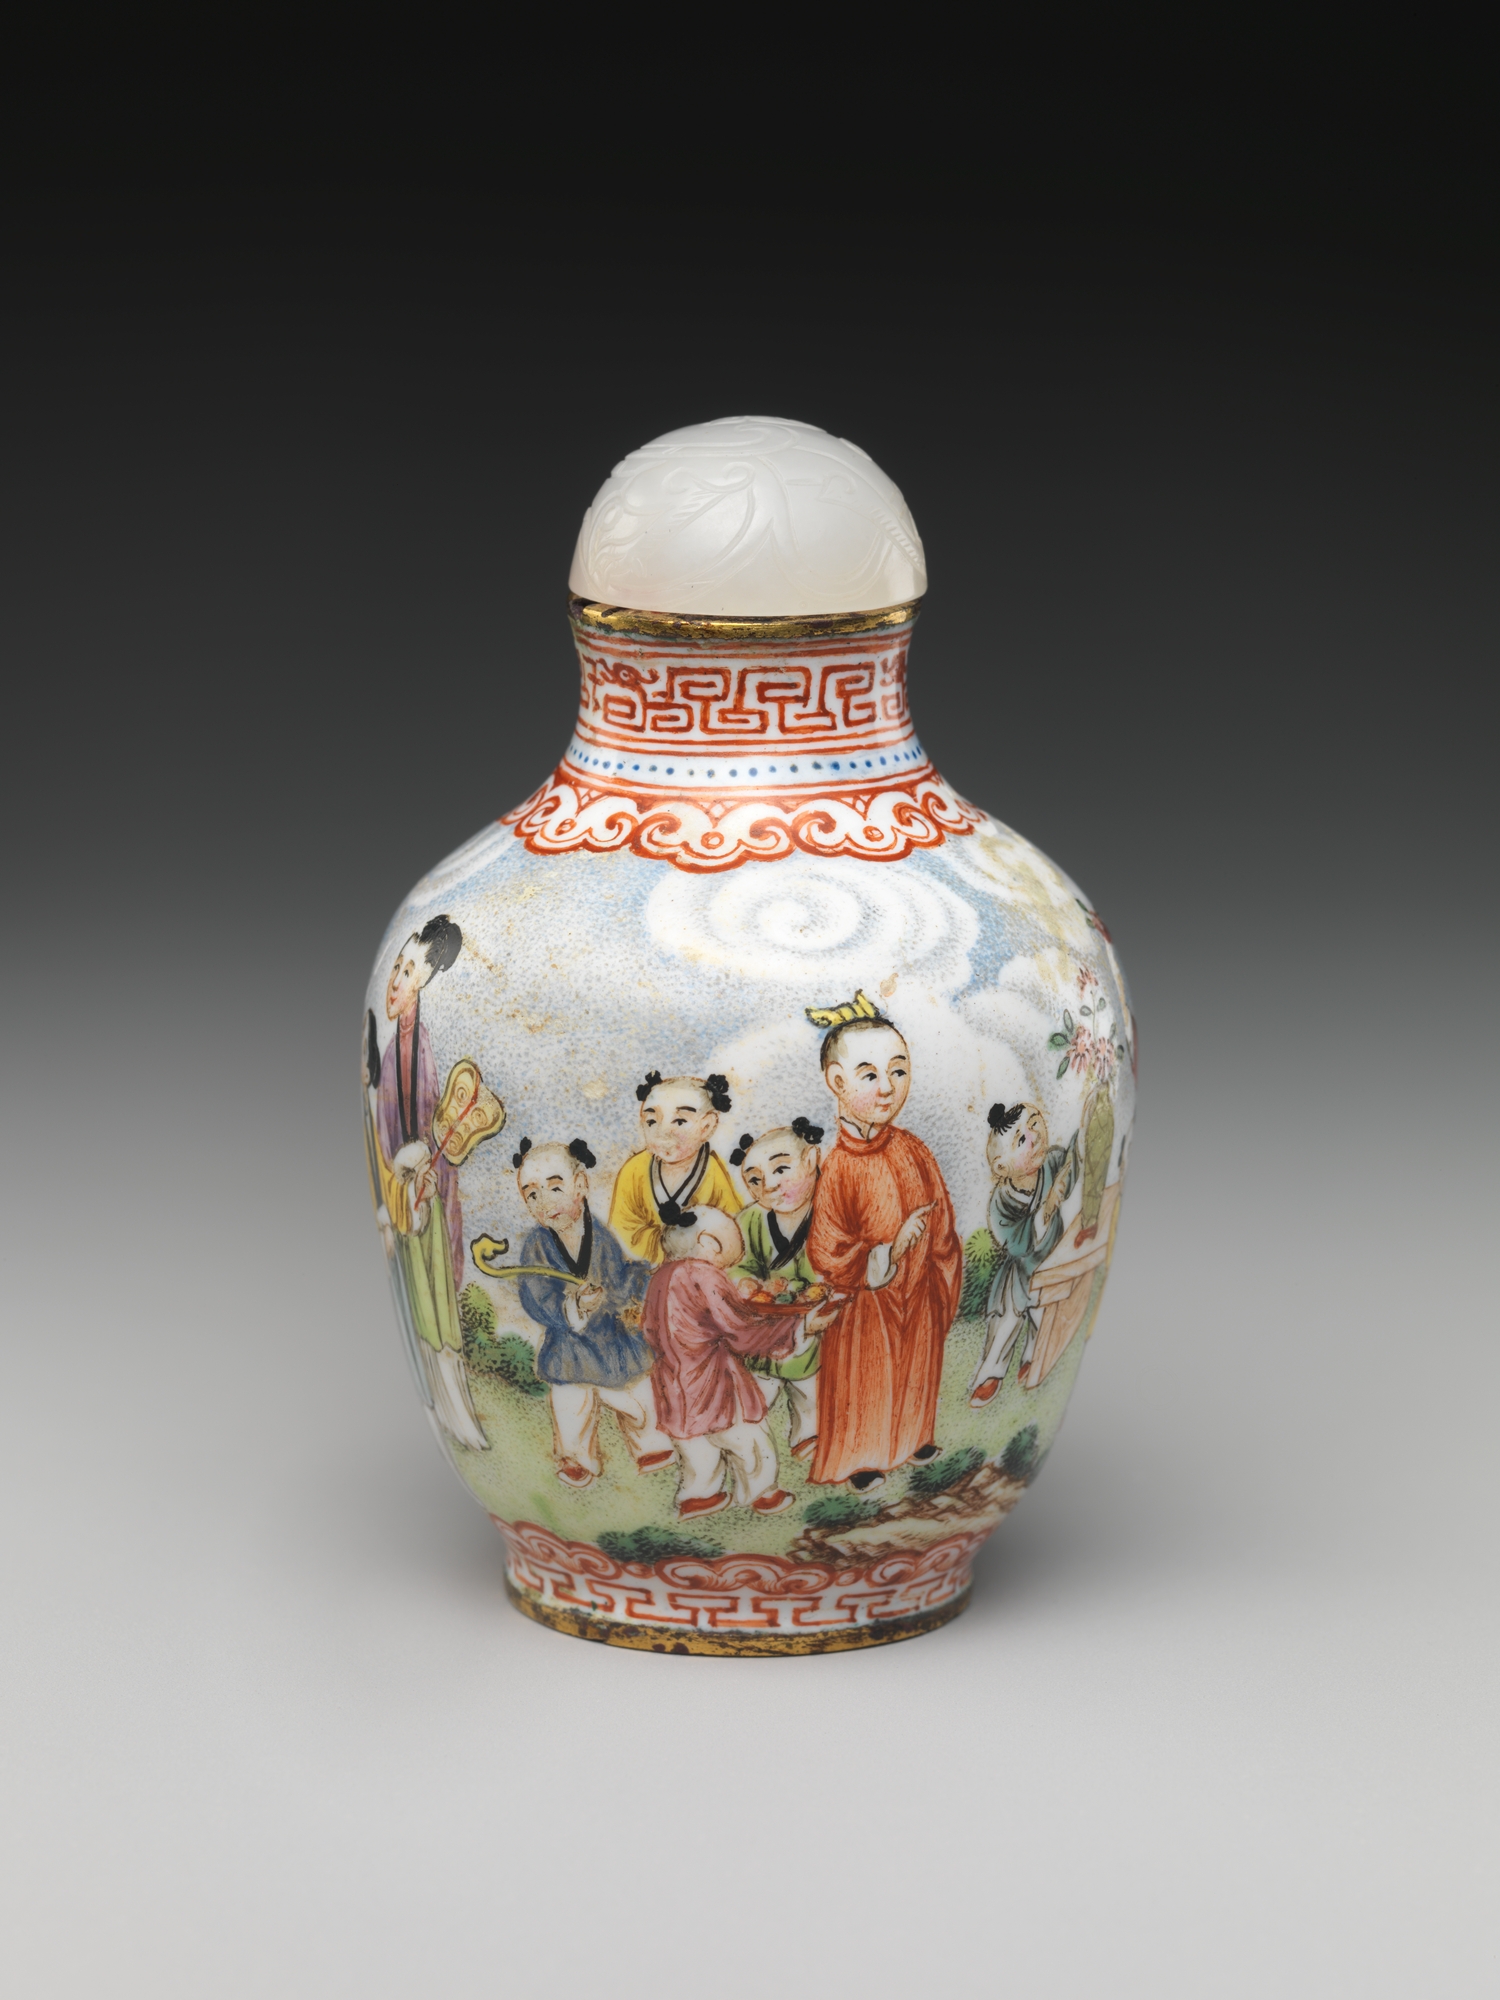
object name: snuff bottle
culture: chinese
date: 1801-1900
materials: enamel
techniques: painting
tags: human figures,children